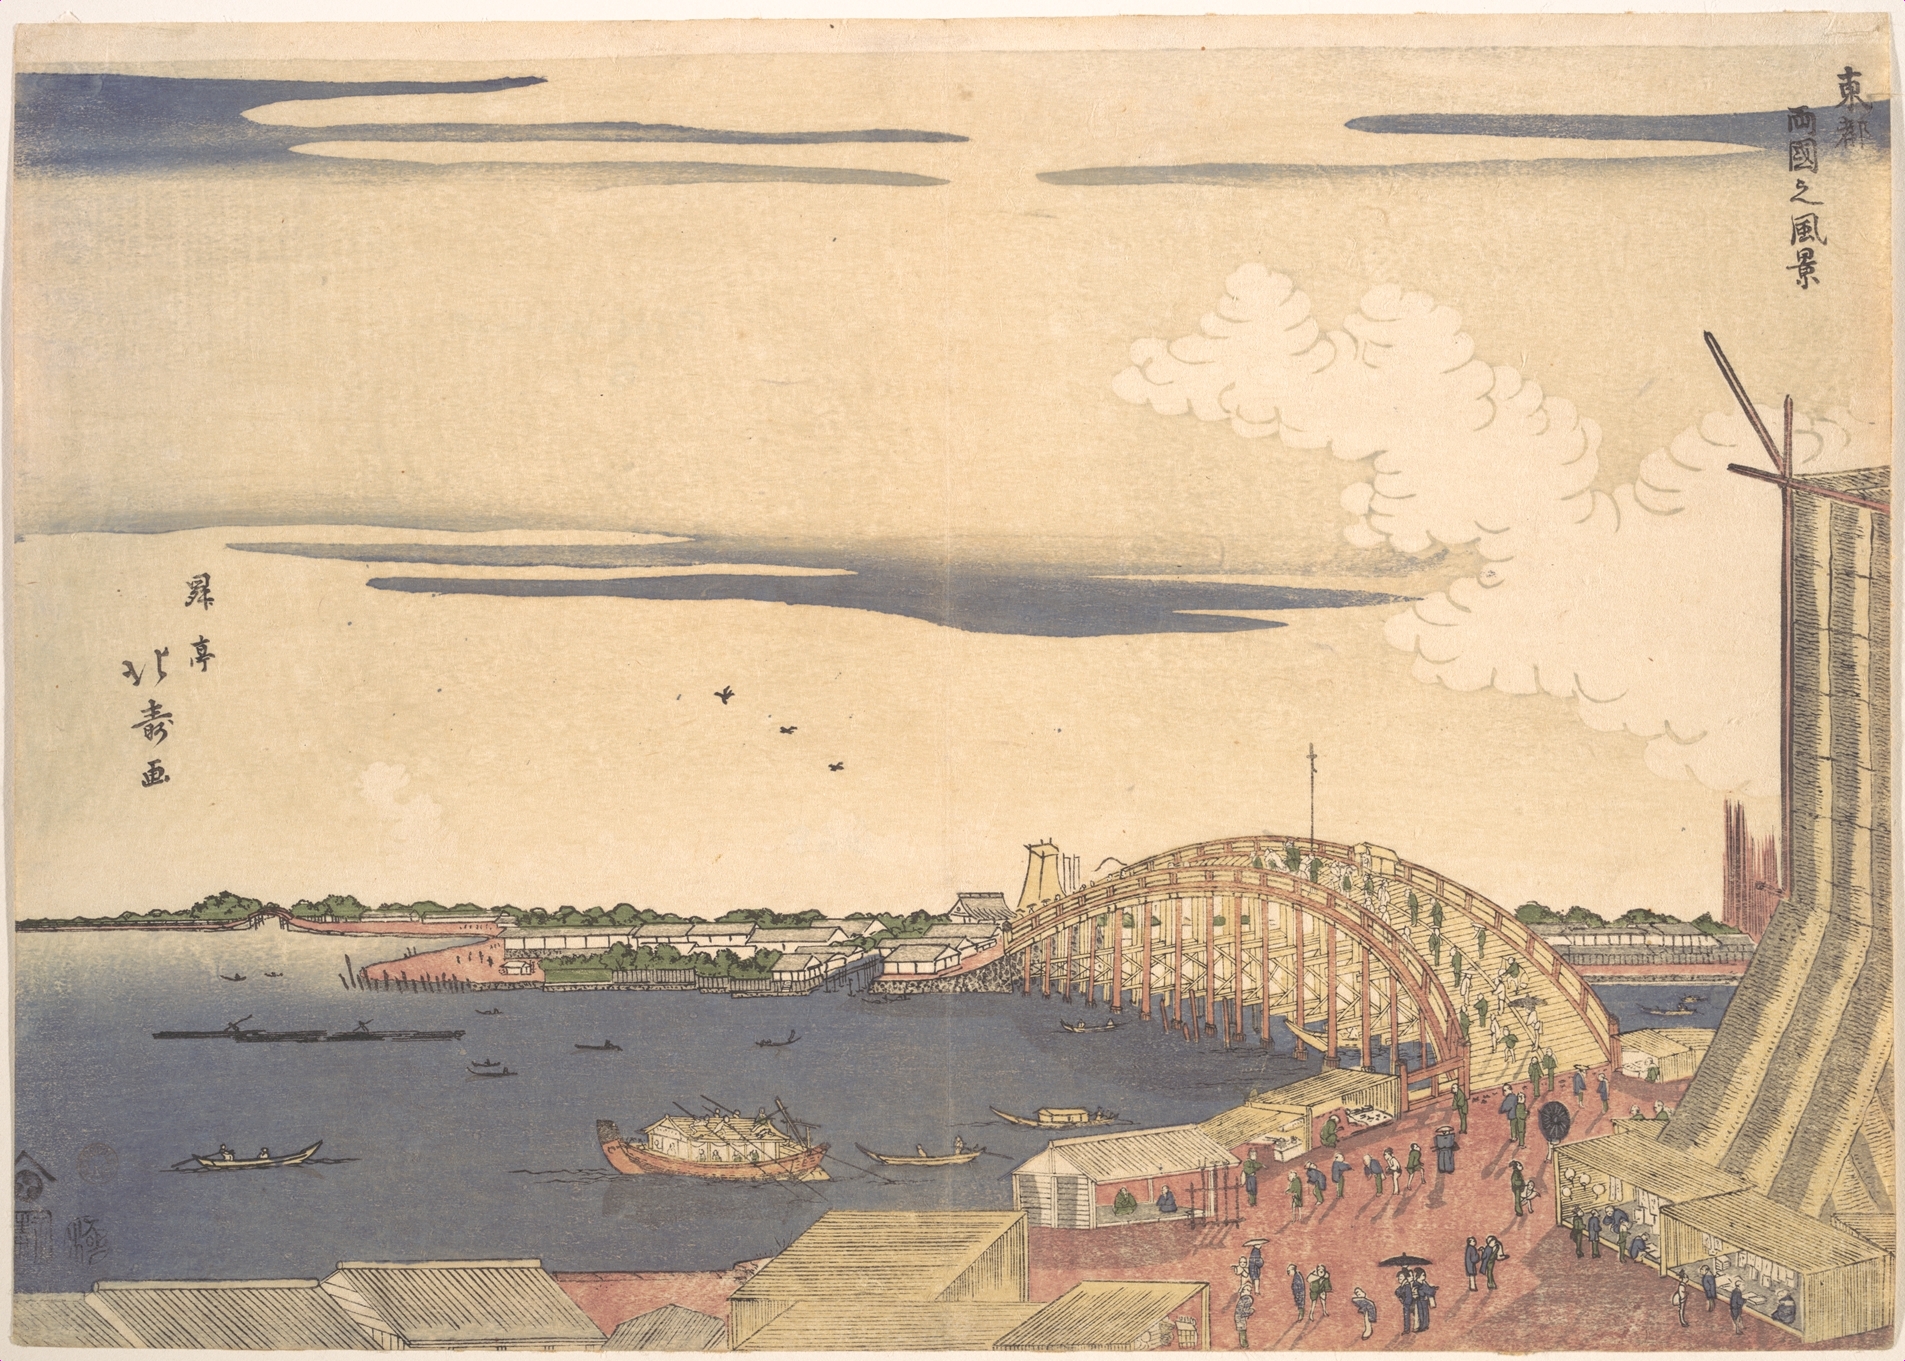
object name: print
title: View of Ryogoku Bridge in the Eastern Capital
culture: japanese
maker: shōtei hokuju 昇亭北寿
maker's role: artist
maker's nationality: japanese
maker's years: 1790-1820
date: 1810-1820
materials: ink, paper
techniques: woodblock print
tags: human figures,houses,bridges,boats